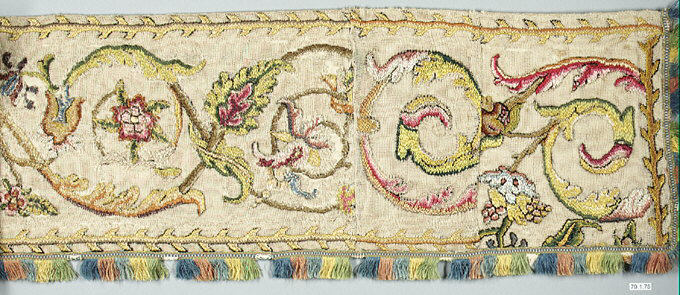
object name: border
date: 1501-1600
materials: silk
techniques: embroidery